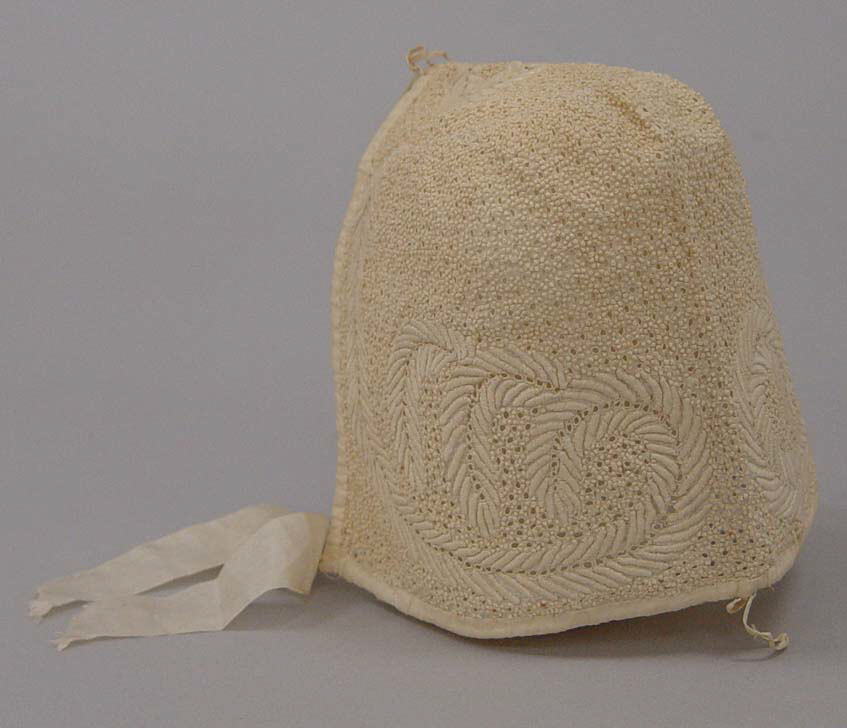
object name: cap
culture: american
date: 1860